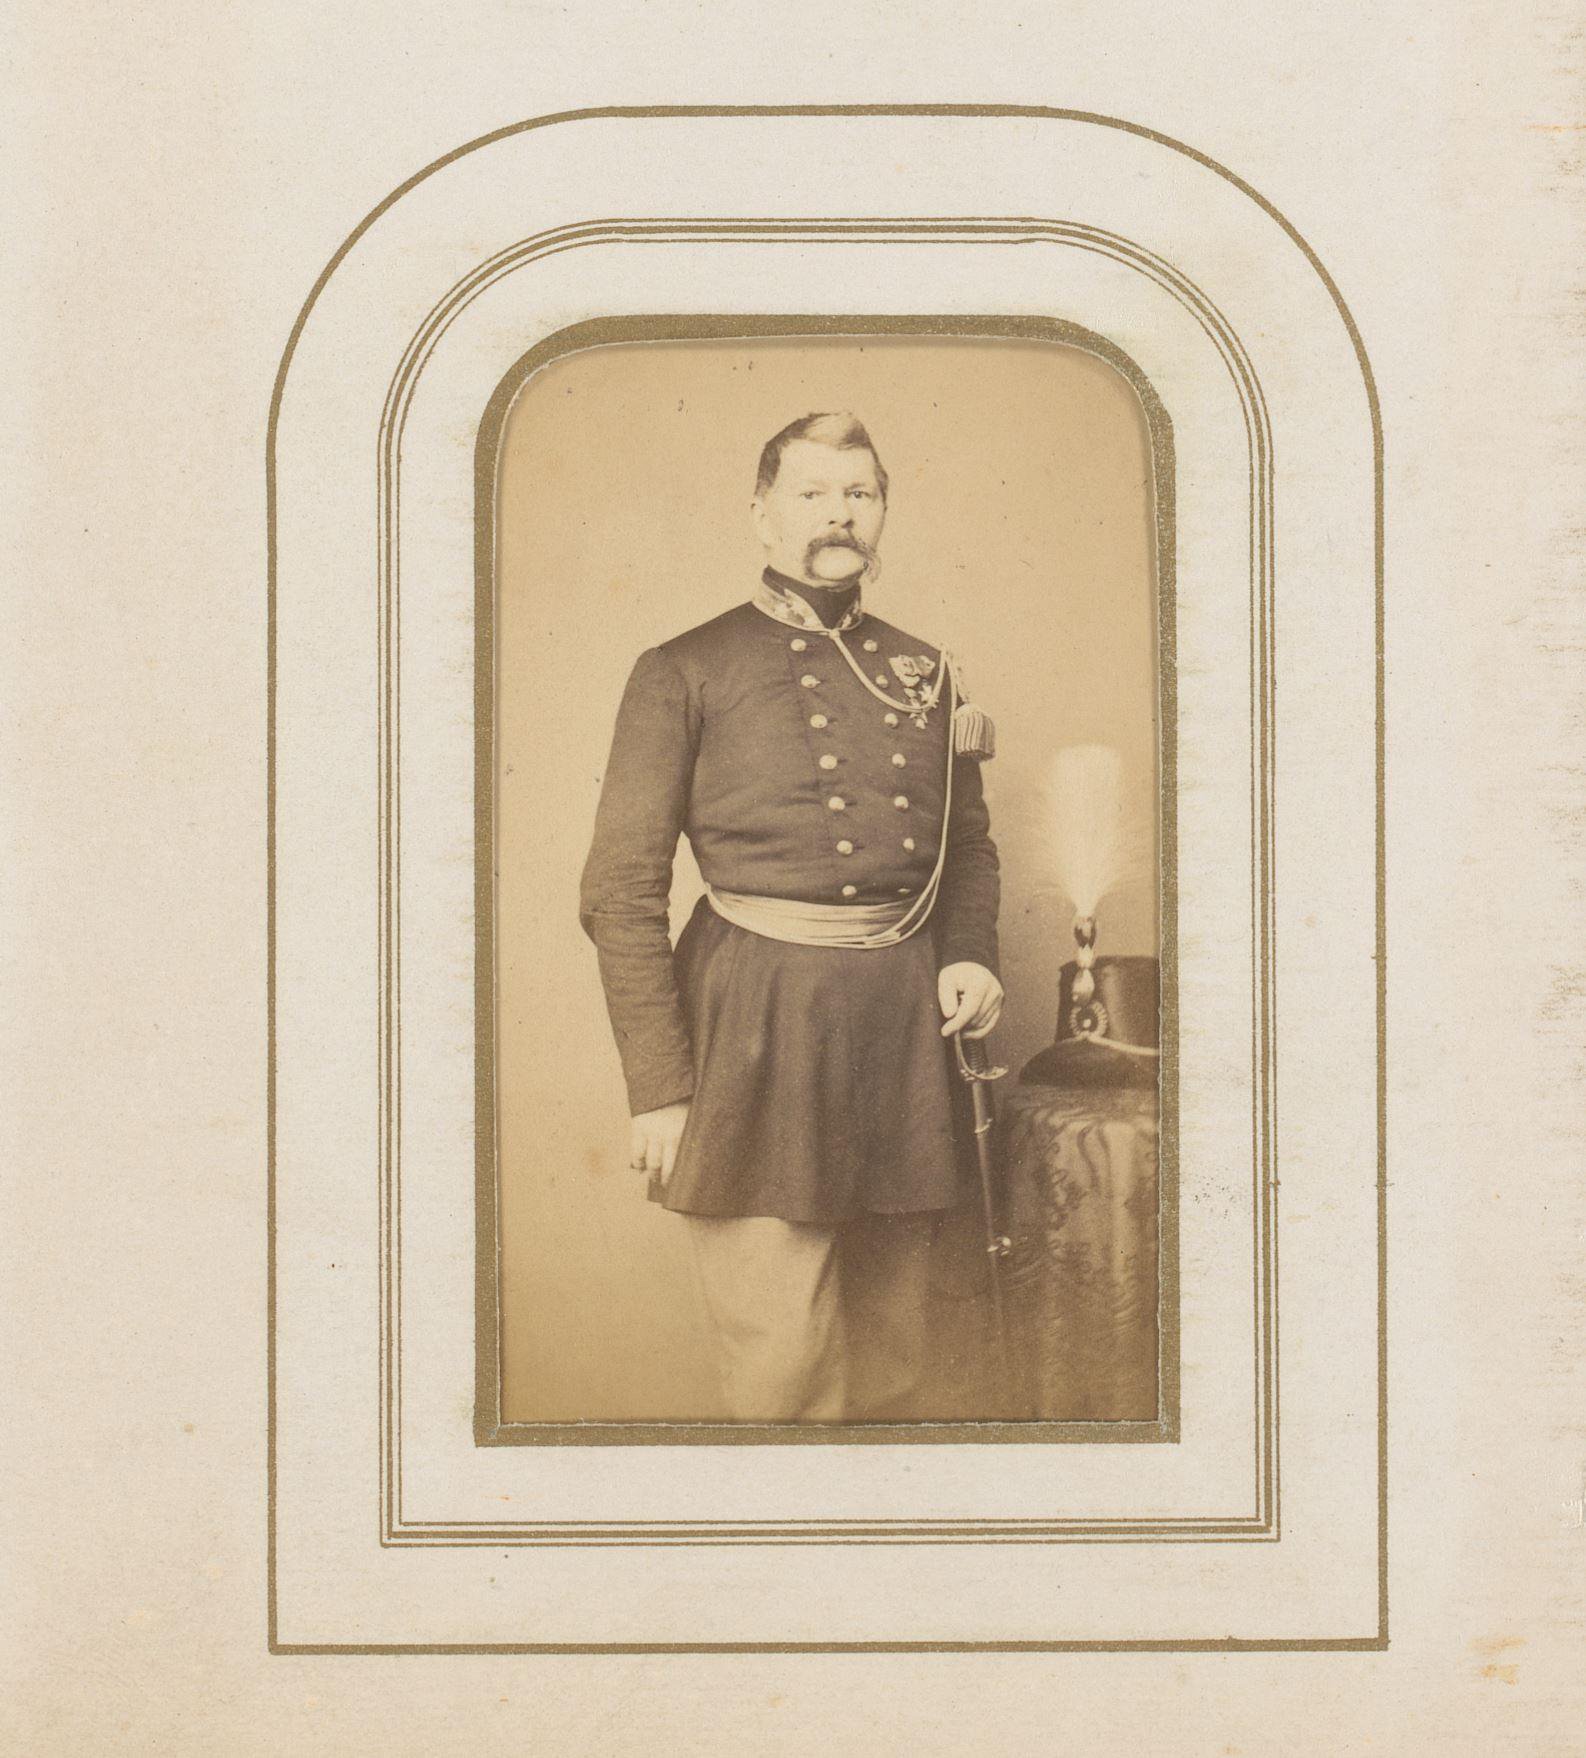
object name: carte de visite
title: Portret van een man in uniform met hoed en zwaard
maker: Anonymous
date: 1860-1890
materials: cardboard, photographic support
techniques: albumen print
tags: historical persons, hacking and thrusting weapons: sword, (military) uniforms